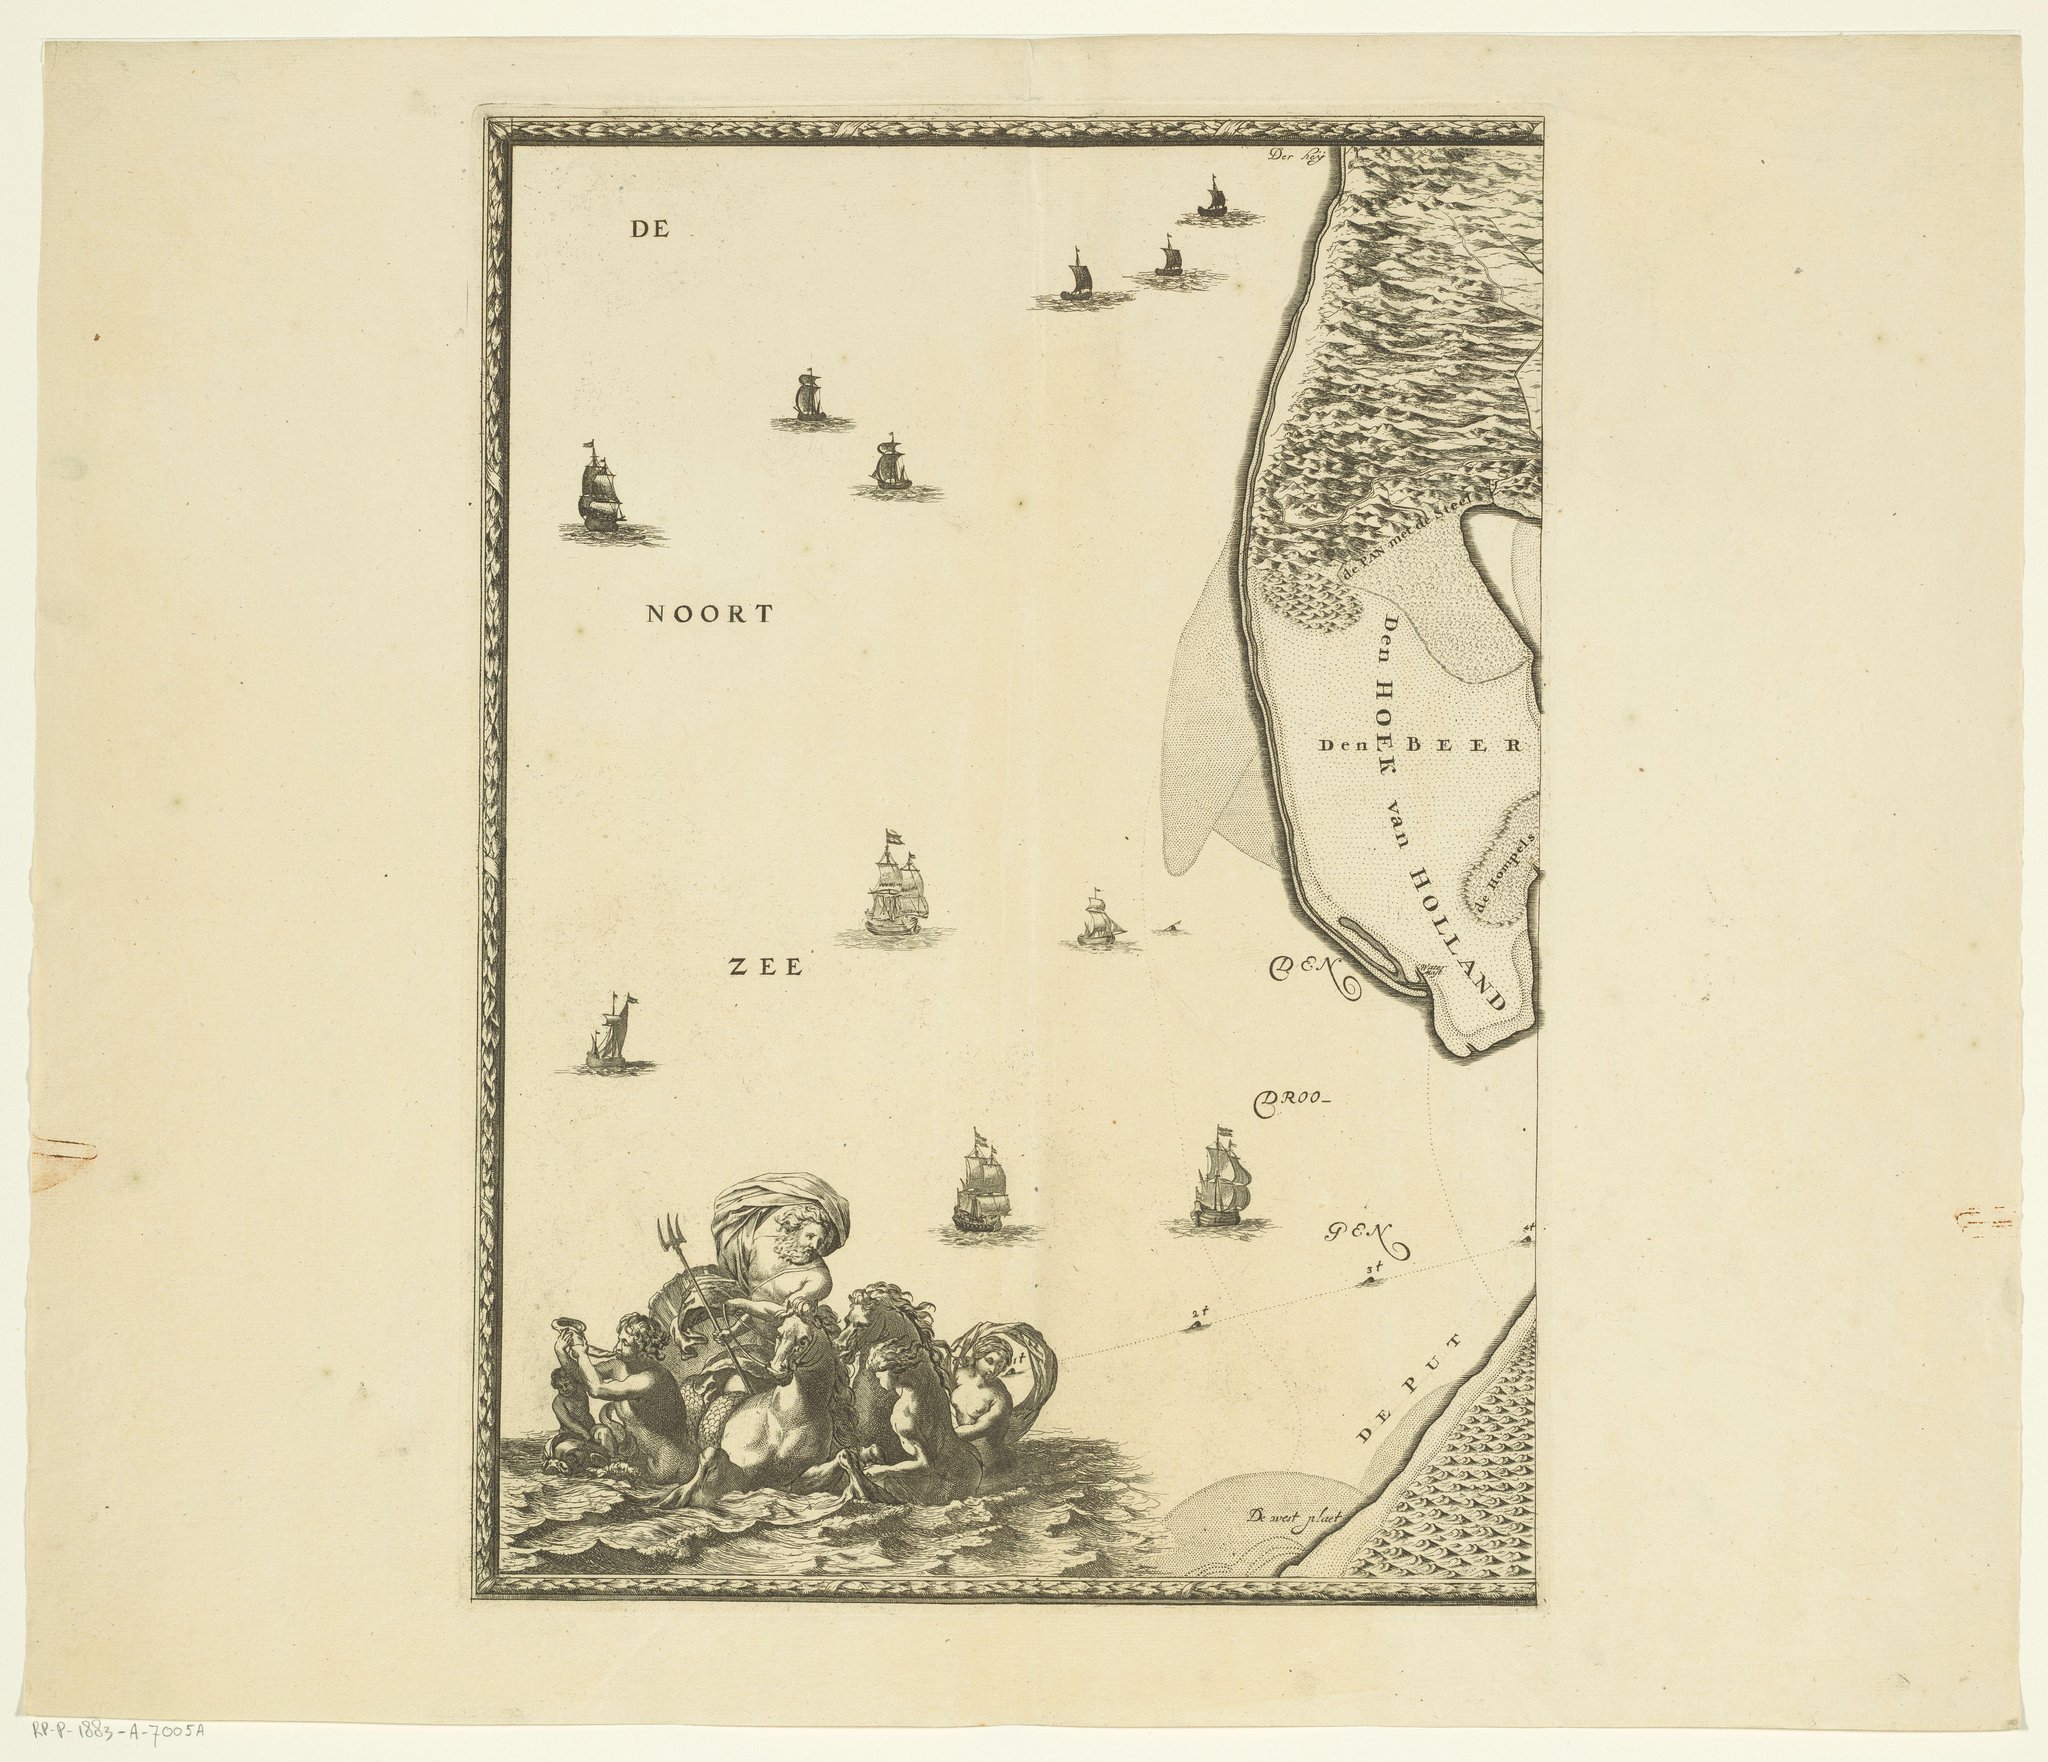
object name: print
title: Kaart van de Maas van Rotterdam tot de Noordzee (eerste deel)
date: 1666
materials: paper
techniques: engraving, etching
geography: rotterdam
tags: 'cornucopia', horn of plenty, triton(s), maps of separate countries or regions, neptune as lord of the sea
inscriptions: collector's mark: Lugt 2228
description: De eerste staat van deze prent is oorspronkelijk bedoeld als onderdeel van de zogenaamde Maaskaart uit 1666, verschenen onder de titel 'Rotterodamum Hollandiae urbs celeberrima et situ portibusque mercaturae opportunissima. Ao. 1665'. Hoewel het jaartal 1665 in de titel stond, blijkt uit archiefonderzoek dat de kaart pas in 1666 gereed was (zie documentatie). Zie ook RP-P-AO-13-5 voor meer informatie.